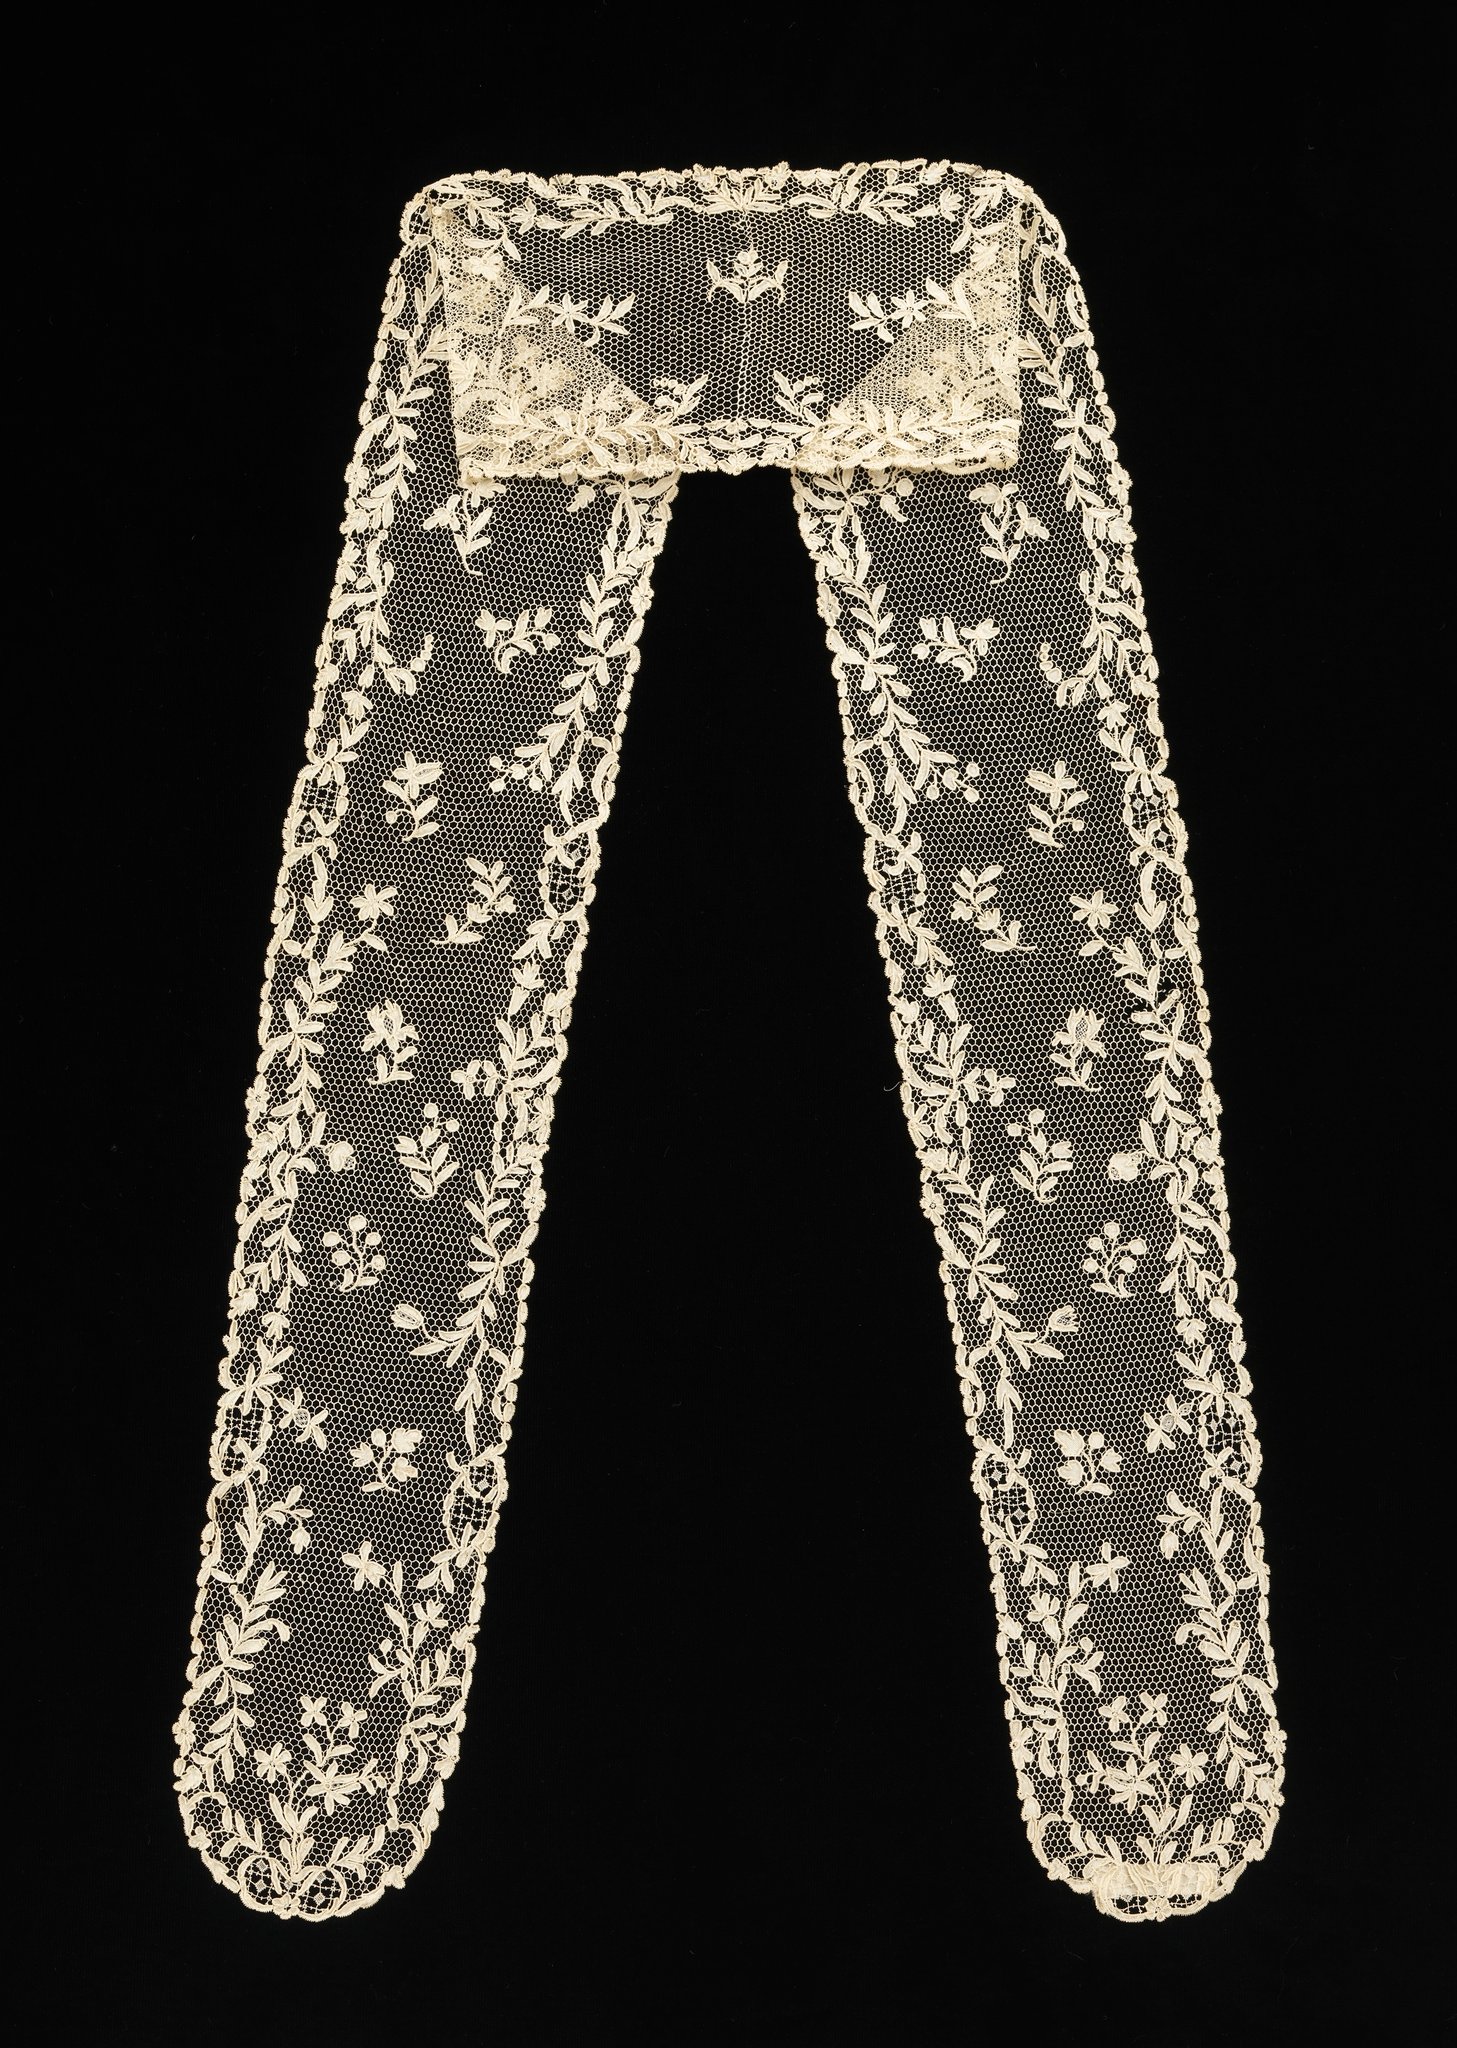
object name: lappet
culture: french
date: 1750-1770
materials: linen